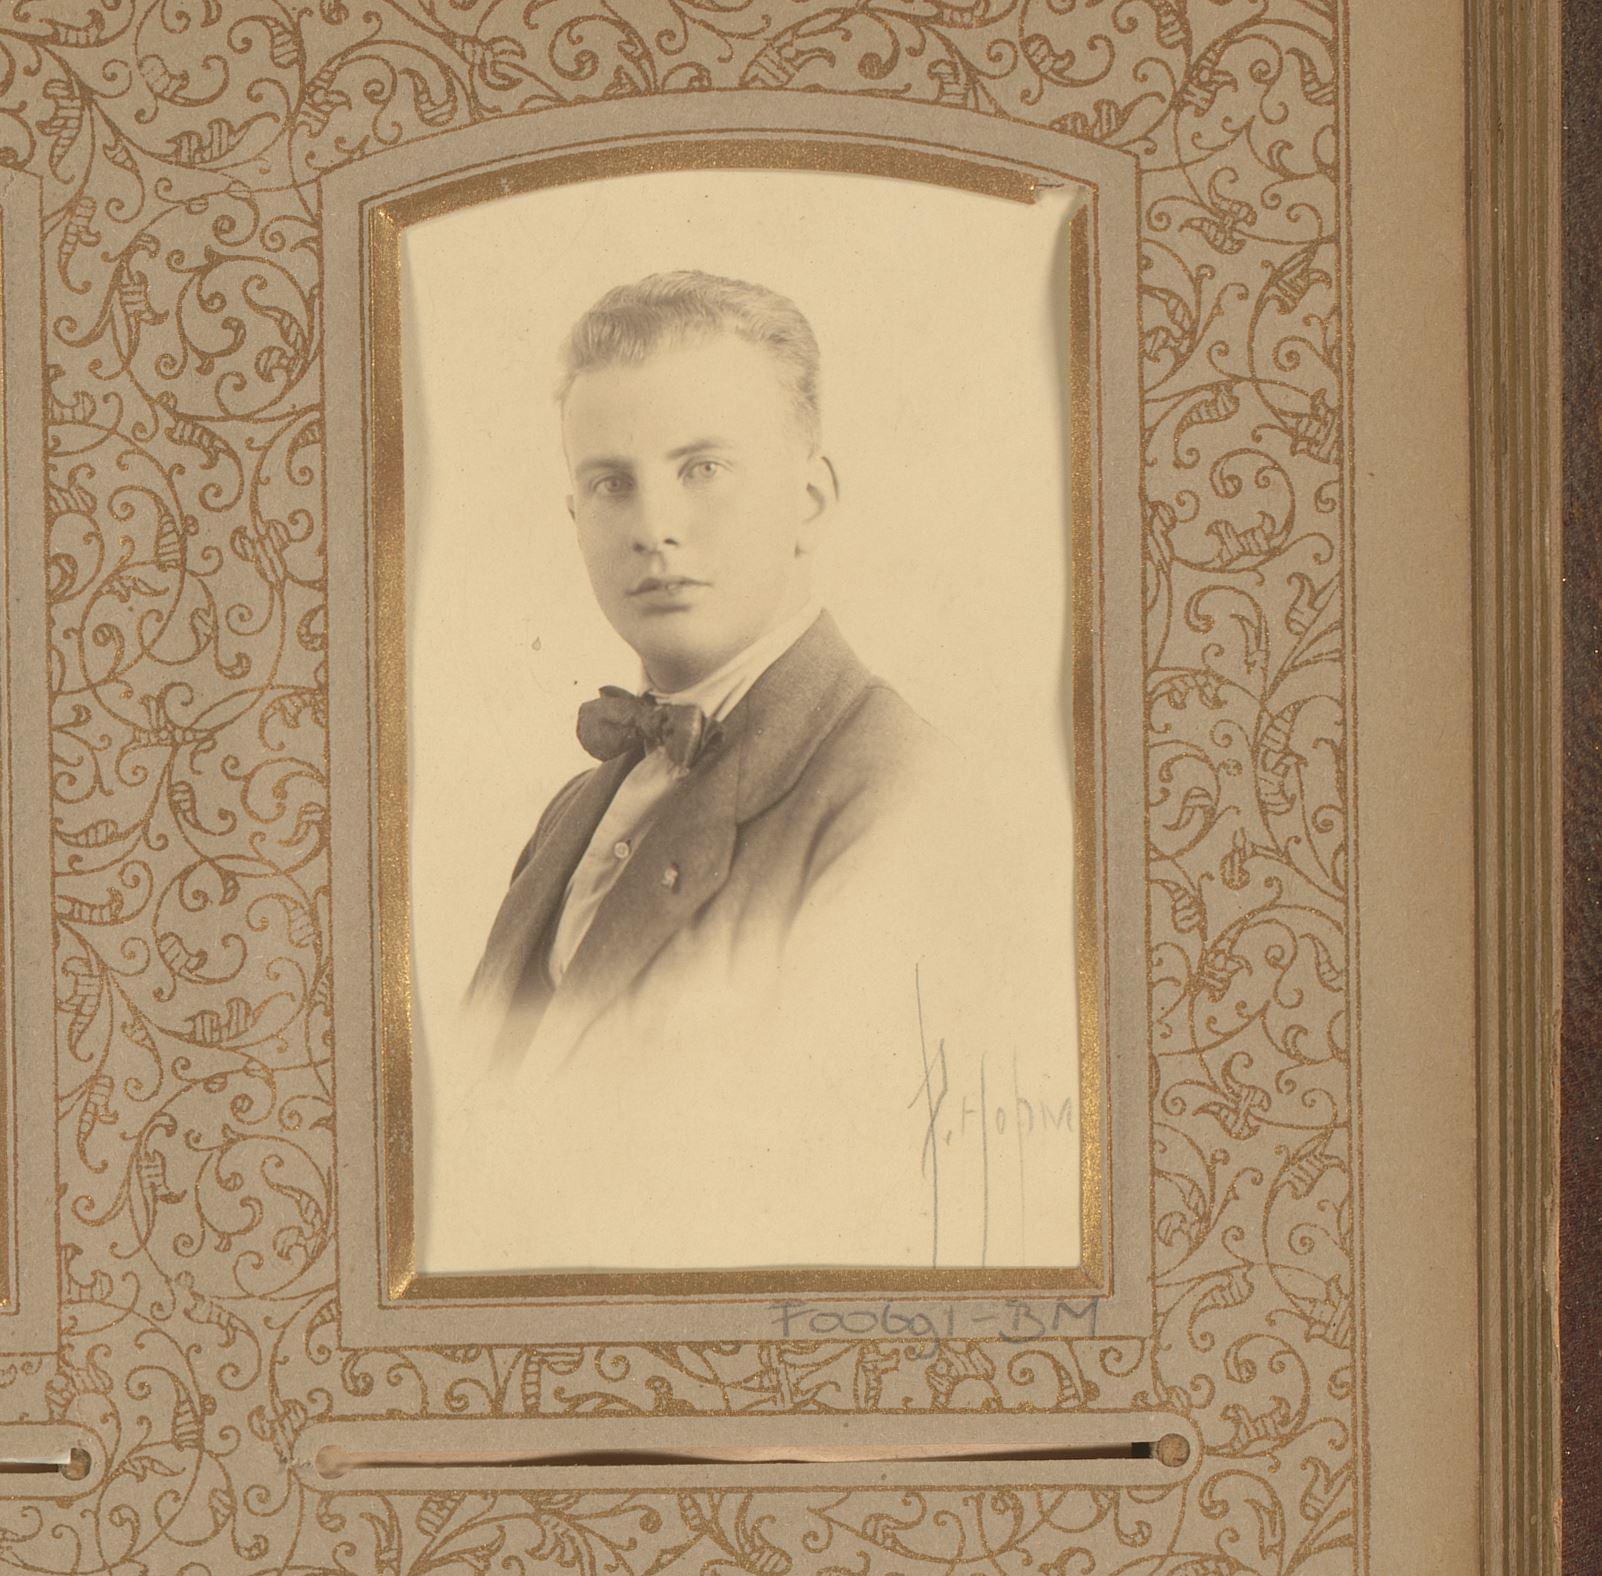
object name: photograph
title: Portret van een jongeman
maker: petrus hendrik hopman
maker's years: 1878-1938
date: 1900-1930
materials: photographic support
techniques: gelatin silver print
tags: historical persons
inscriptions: name: ‘P. Hopman’